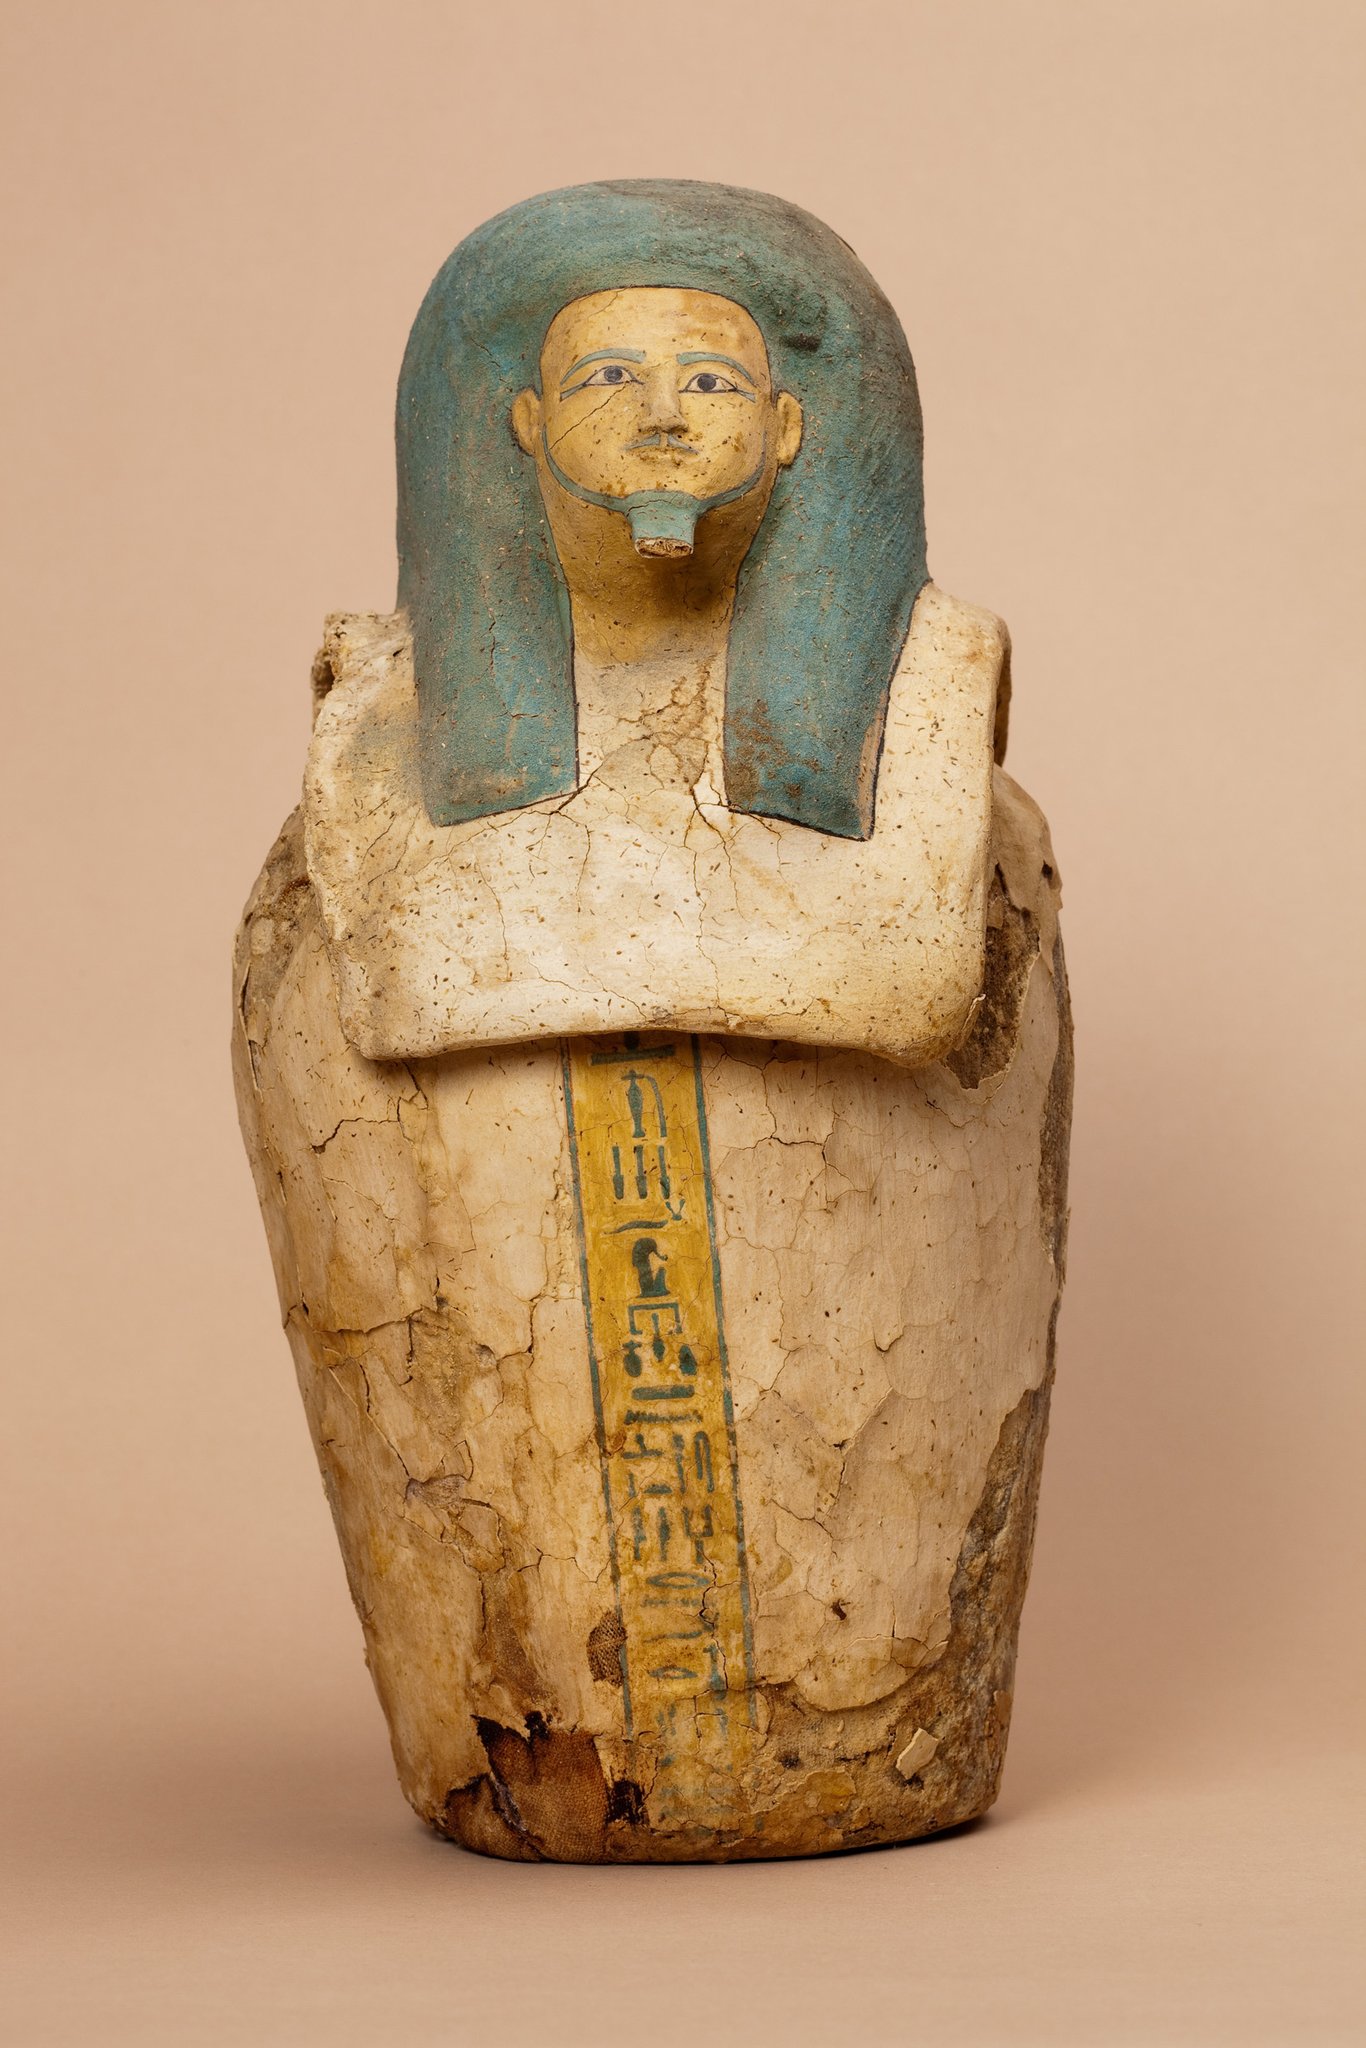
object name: canopic jar, kay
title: Canopic jar of Kay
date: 1981-1802 BCE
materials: linen, plaster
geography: egypt